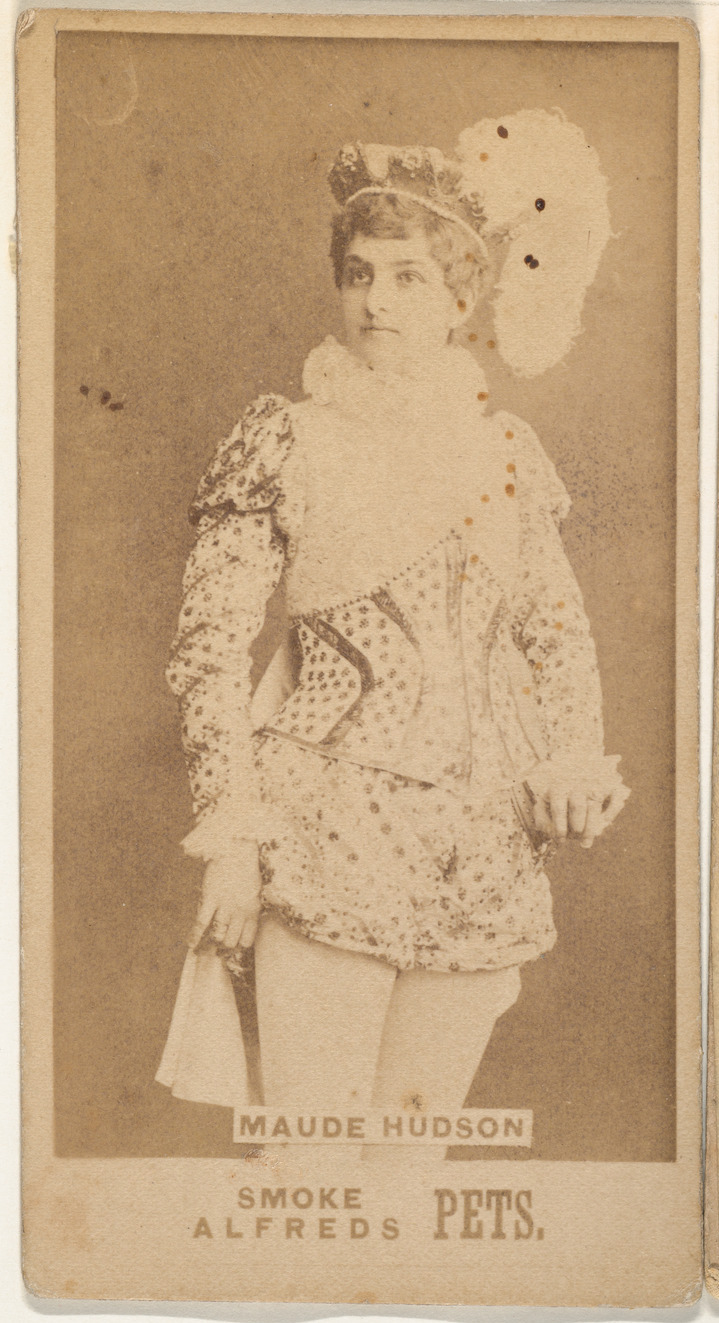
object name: photograph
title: Maude Hudson, from the Actresses series (N671), promoting Alfreds Pets Tobacco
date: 1888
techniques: albumen silver print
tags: portraits,women,actresses